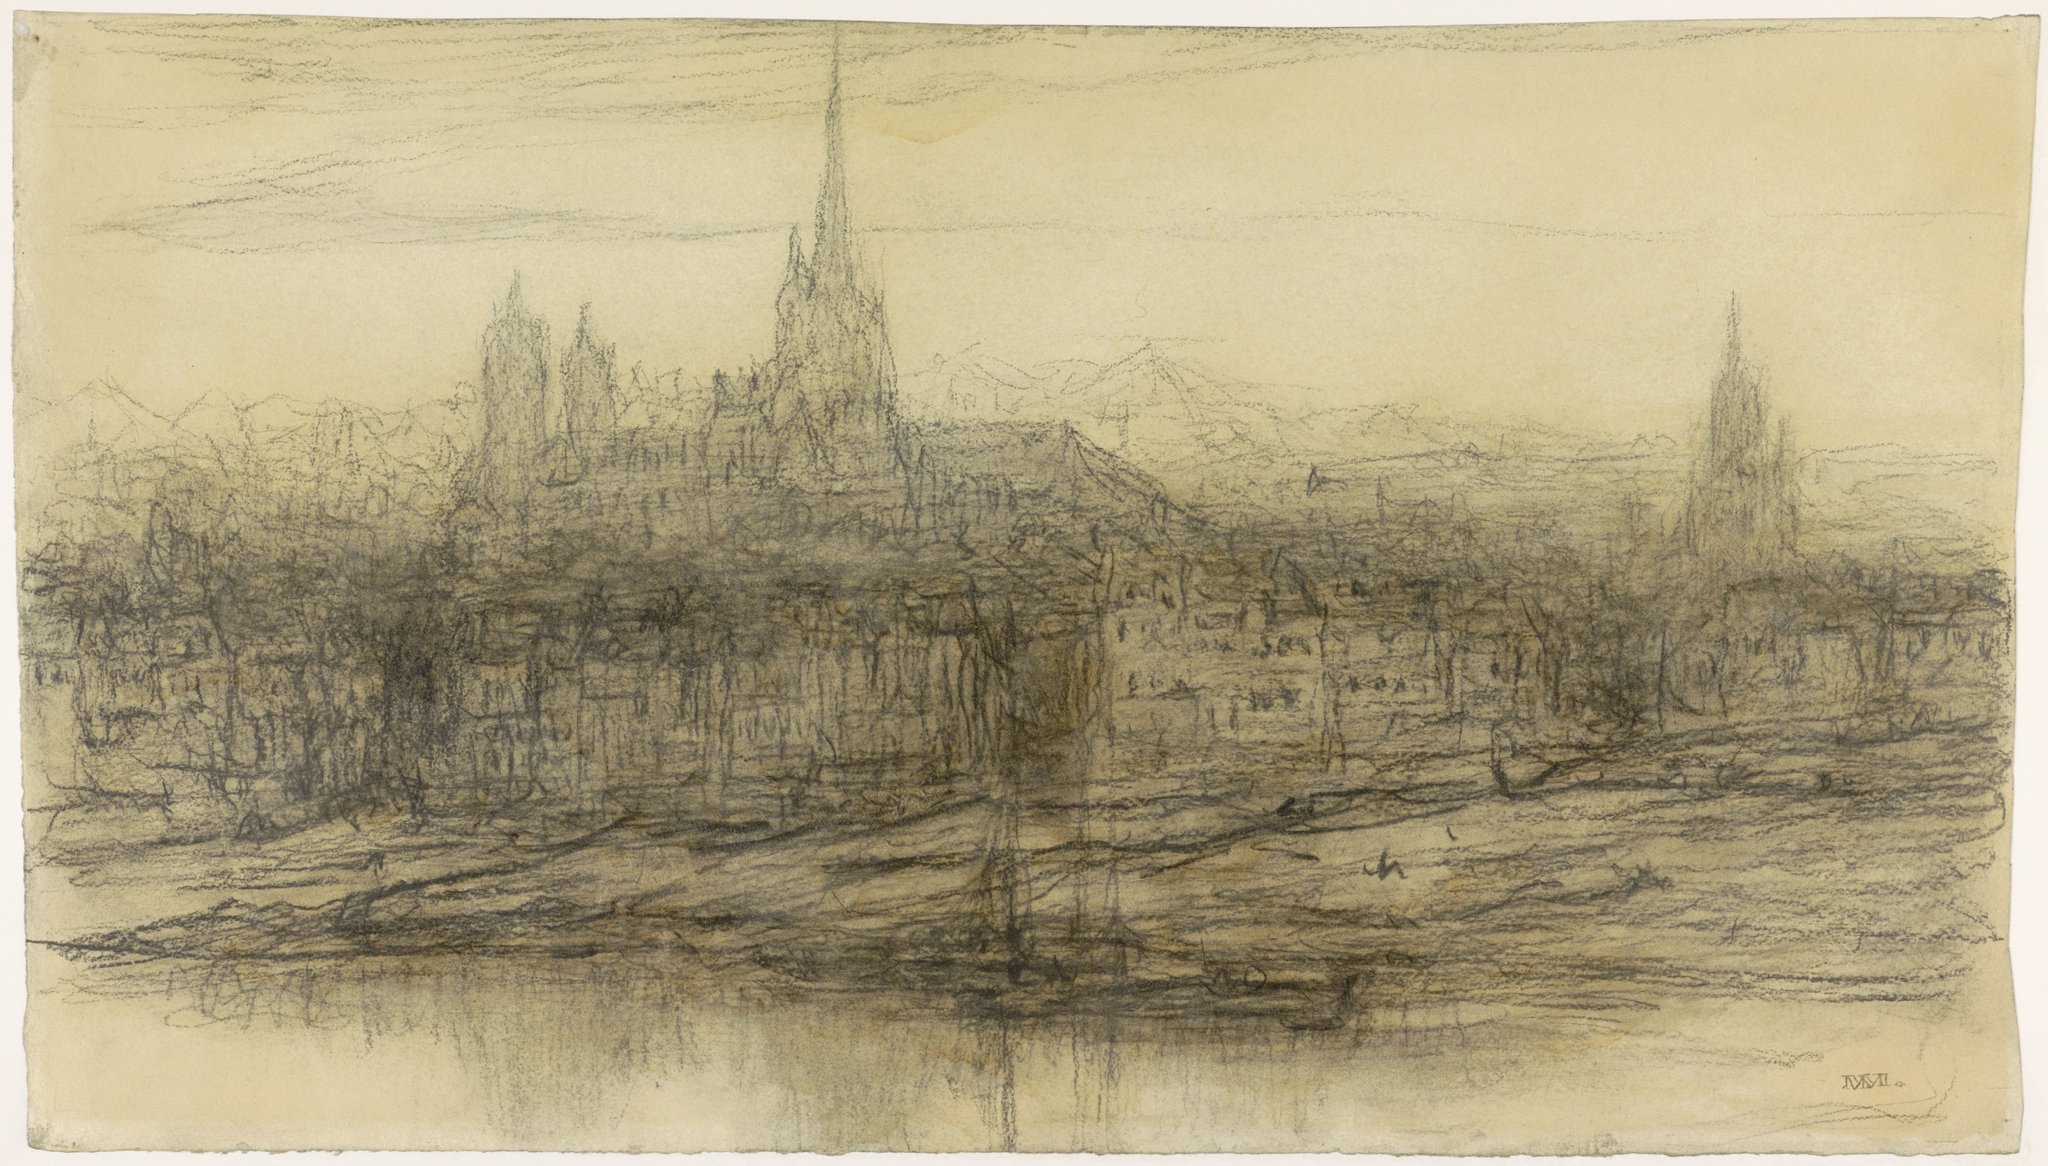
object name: drawing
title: View of Rouen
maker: matthijs maris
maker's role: draughtsman, painter, print maker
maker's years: 1839-1917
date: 1870-1872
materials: chalk, paper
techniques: varnishing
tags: prospect of city, town panorama, silhouette of city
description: This drawing probably originated in Maris’ atelier in Paris. He used sketches he had made on the spot in Rouen. Just like in his earlier views of Lausanne, he chose a vantage point from which the cathedral dominates the horizon. He heightened the church tower by elongating its spire.